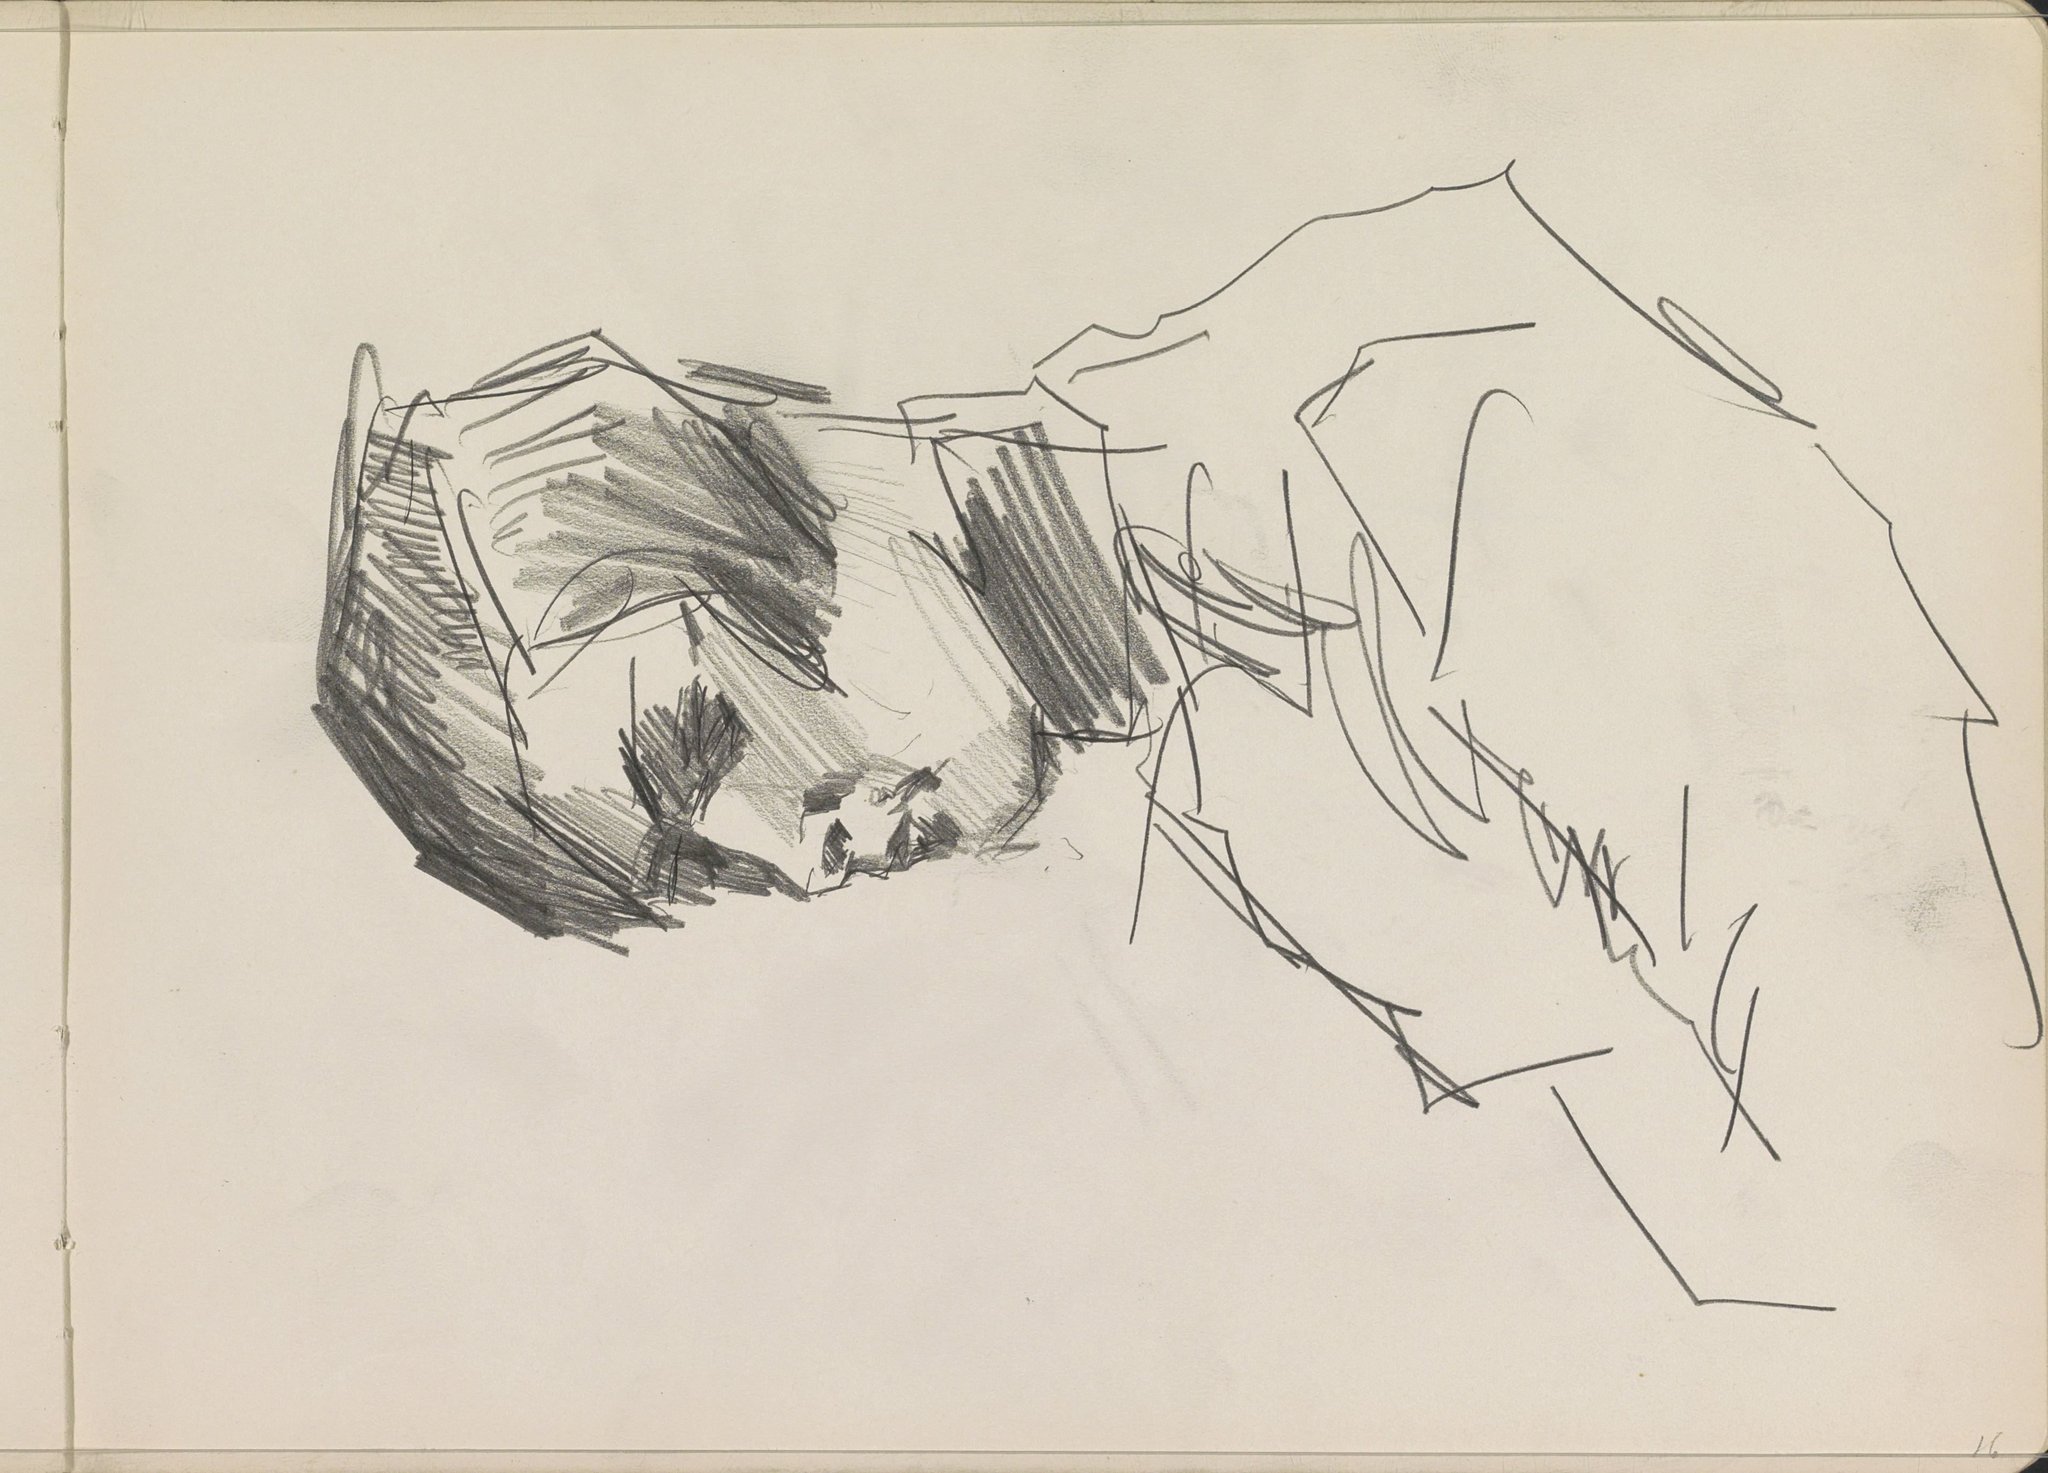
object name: sketchbook leaf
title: Vrouw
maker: isaac israels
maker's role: draughtsman, painter, print maker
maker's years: 1865-1934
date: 1915-1934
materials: paper, pencil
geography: the hague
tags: adult woman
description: Blad 16 recto uit schetsboek VI met 33 bladen.